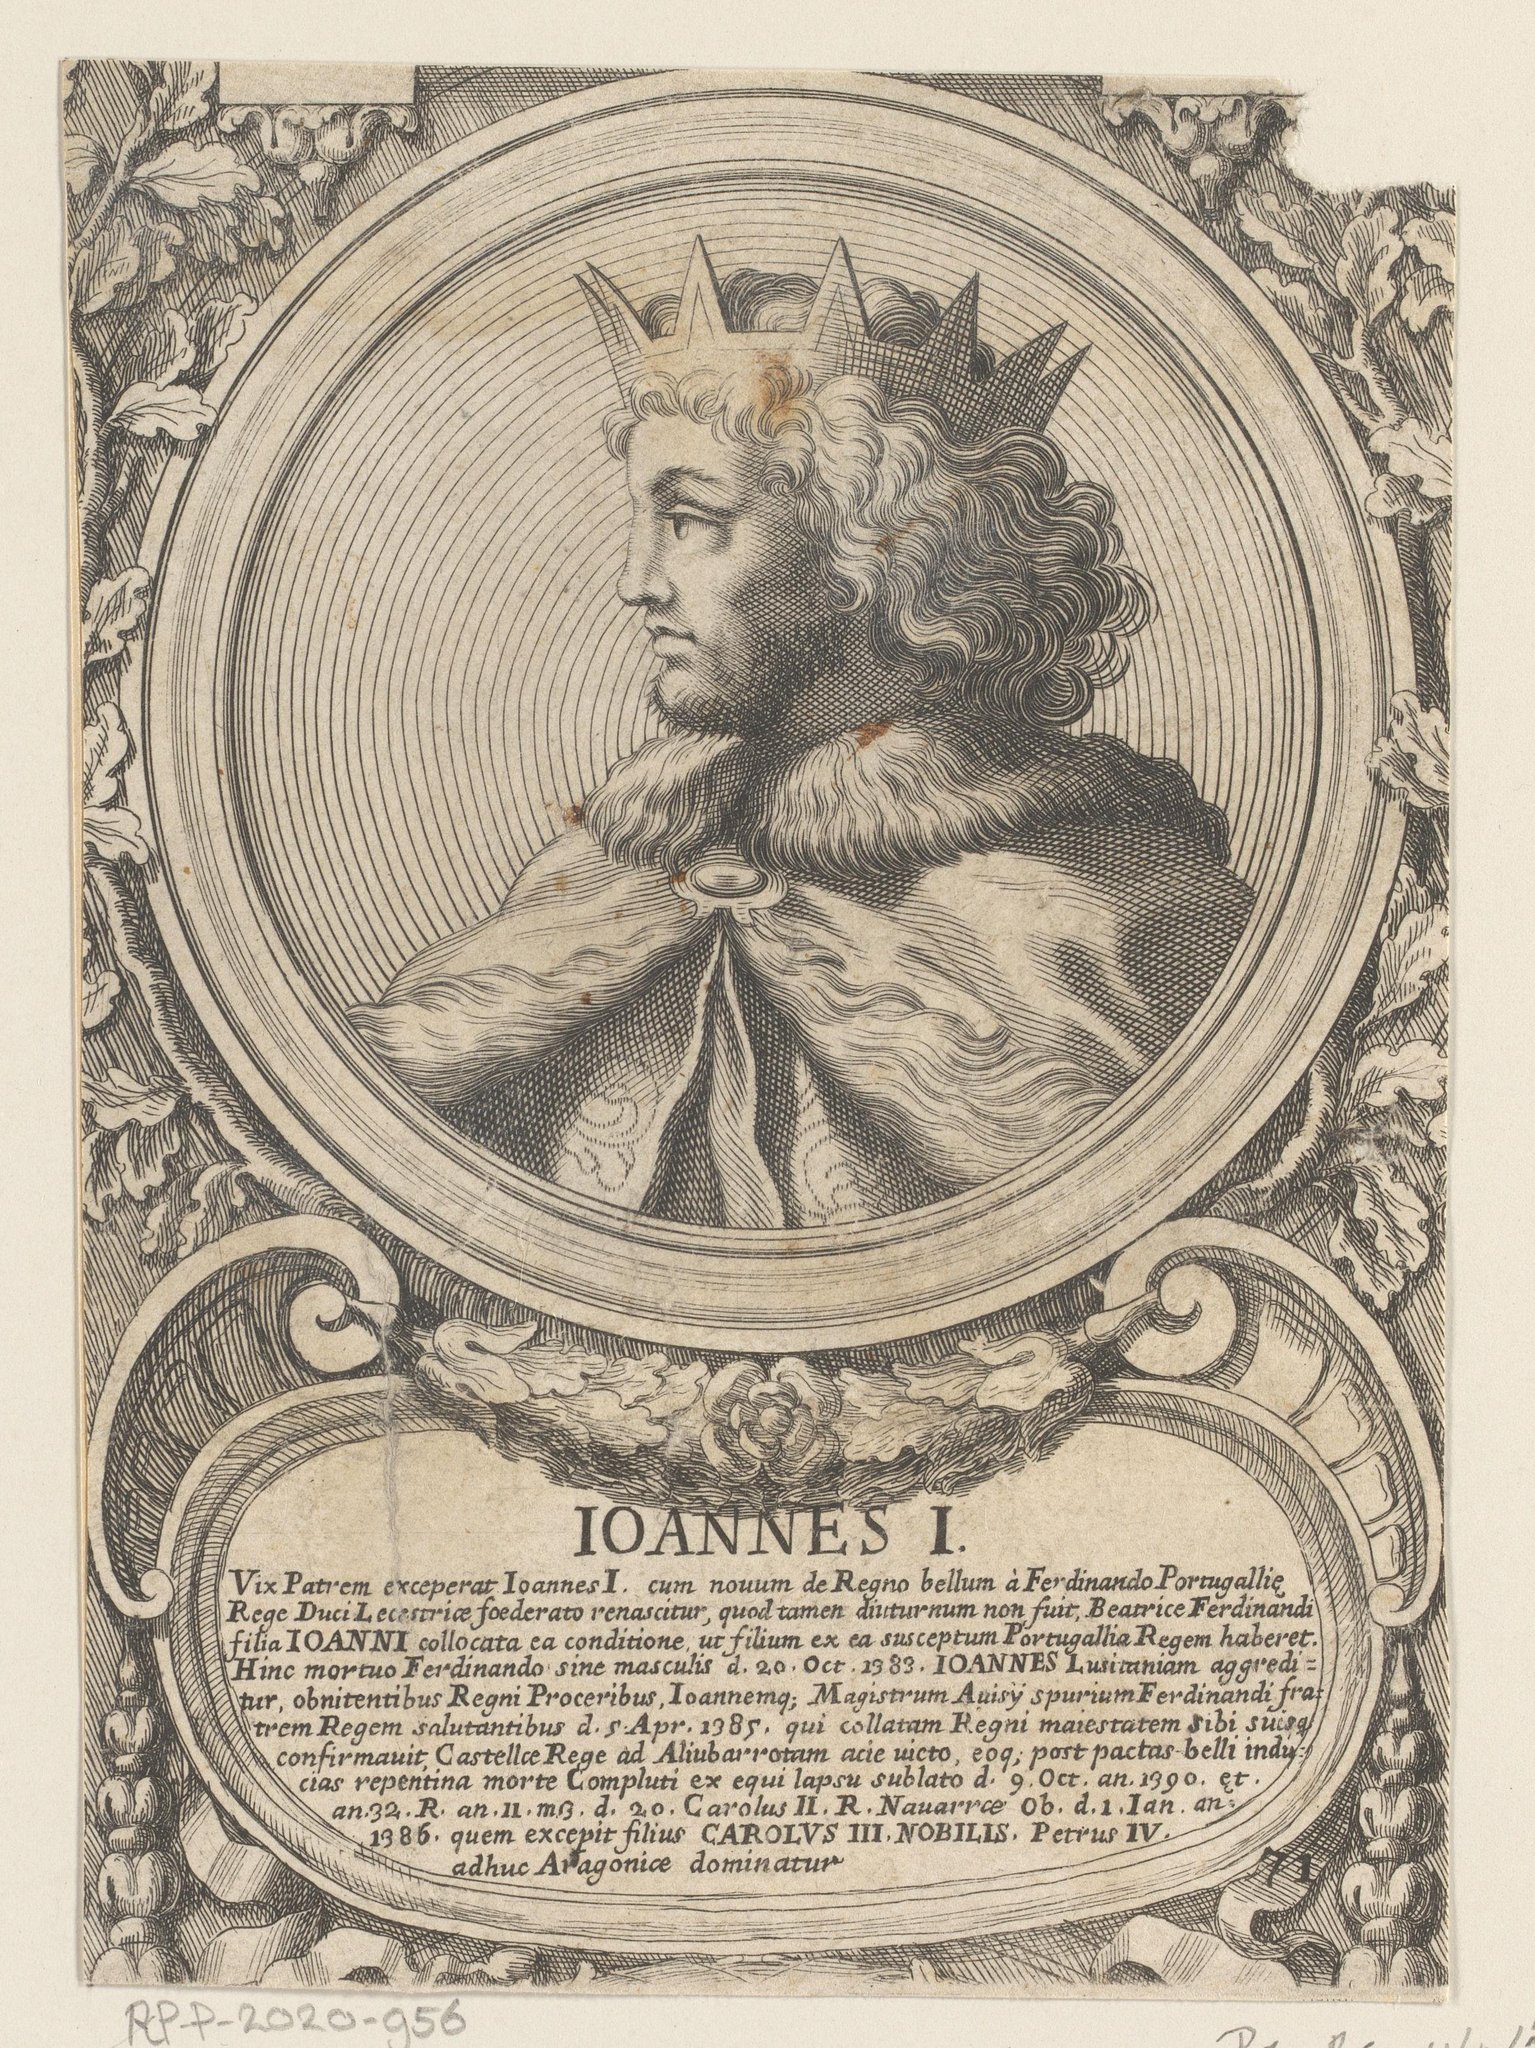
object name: print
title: Joannes I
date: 1685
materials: paper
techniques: engraving, etching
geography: rome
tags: historical persons, ruler, sovereign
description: Portret afkomstig van een grote prent, getiteld 'Series Chronologica et Imagines Regu Hispaniae ab Ataulpho ad Carolum II', bestaande uit tien bladen die samengevoegd konden worden, uitgegeven door Giovanni Giacomo de' Rossi in 1685.